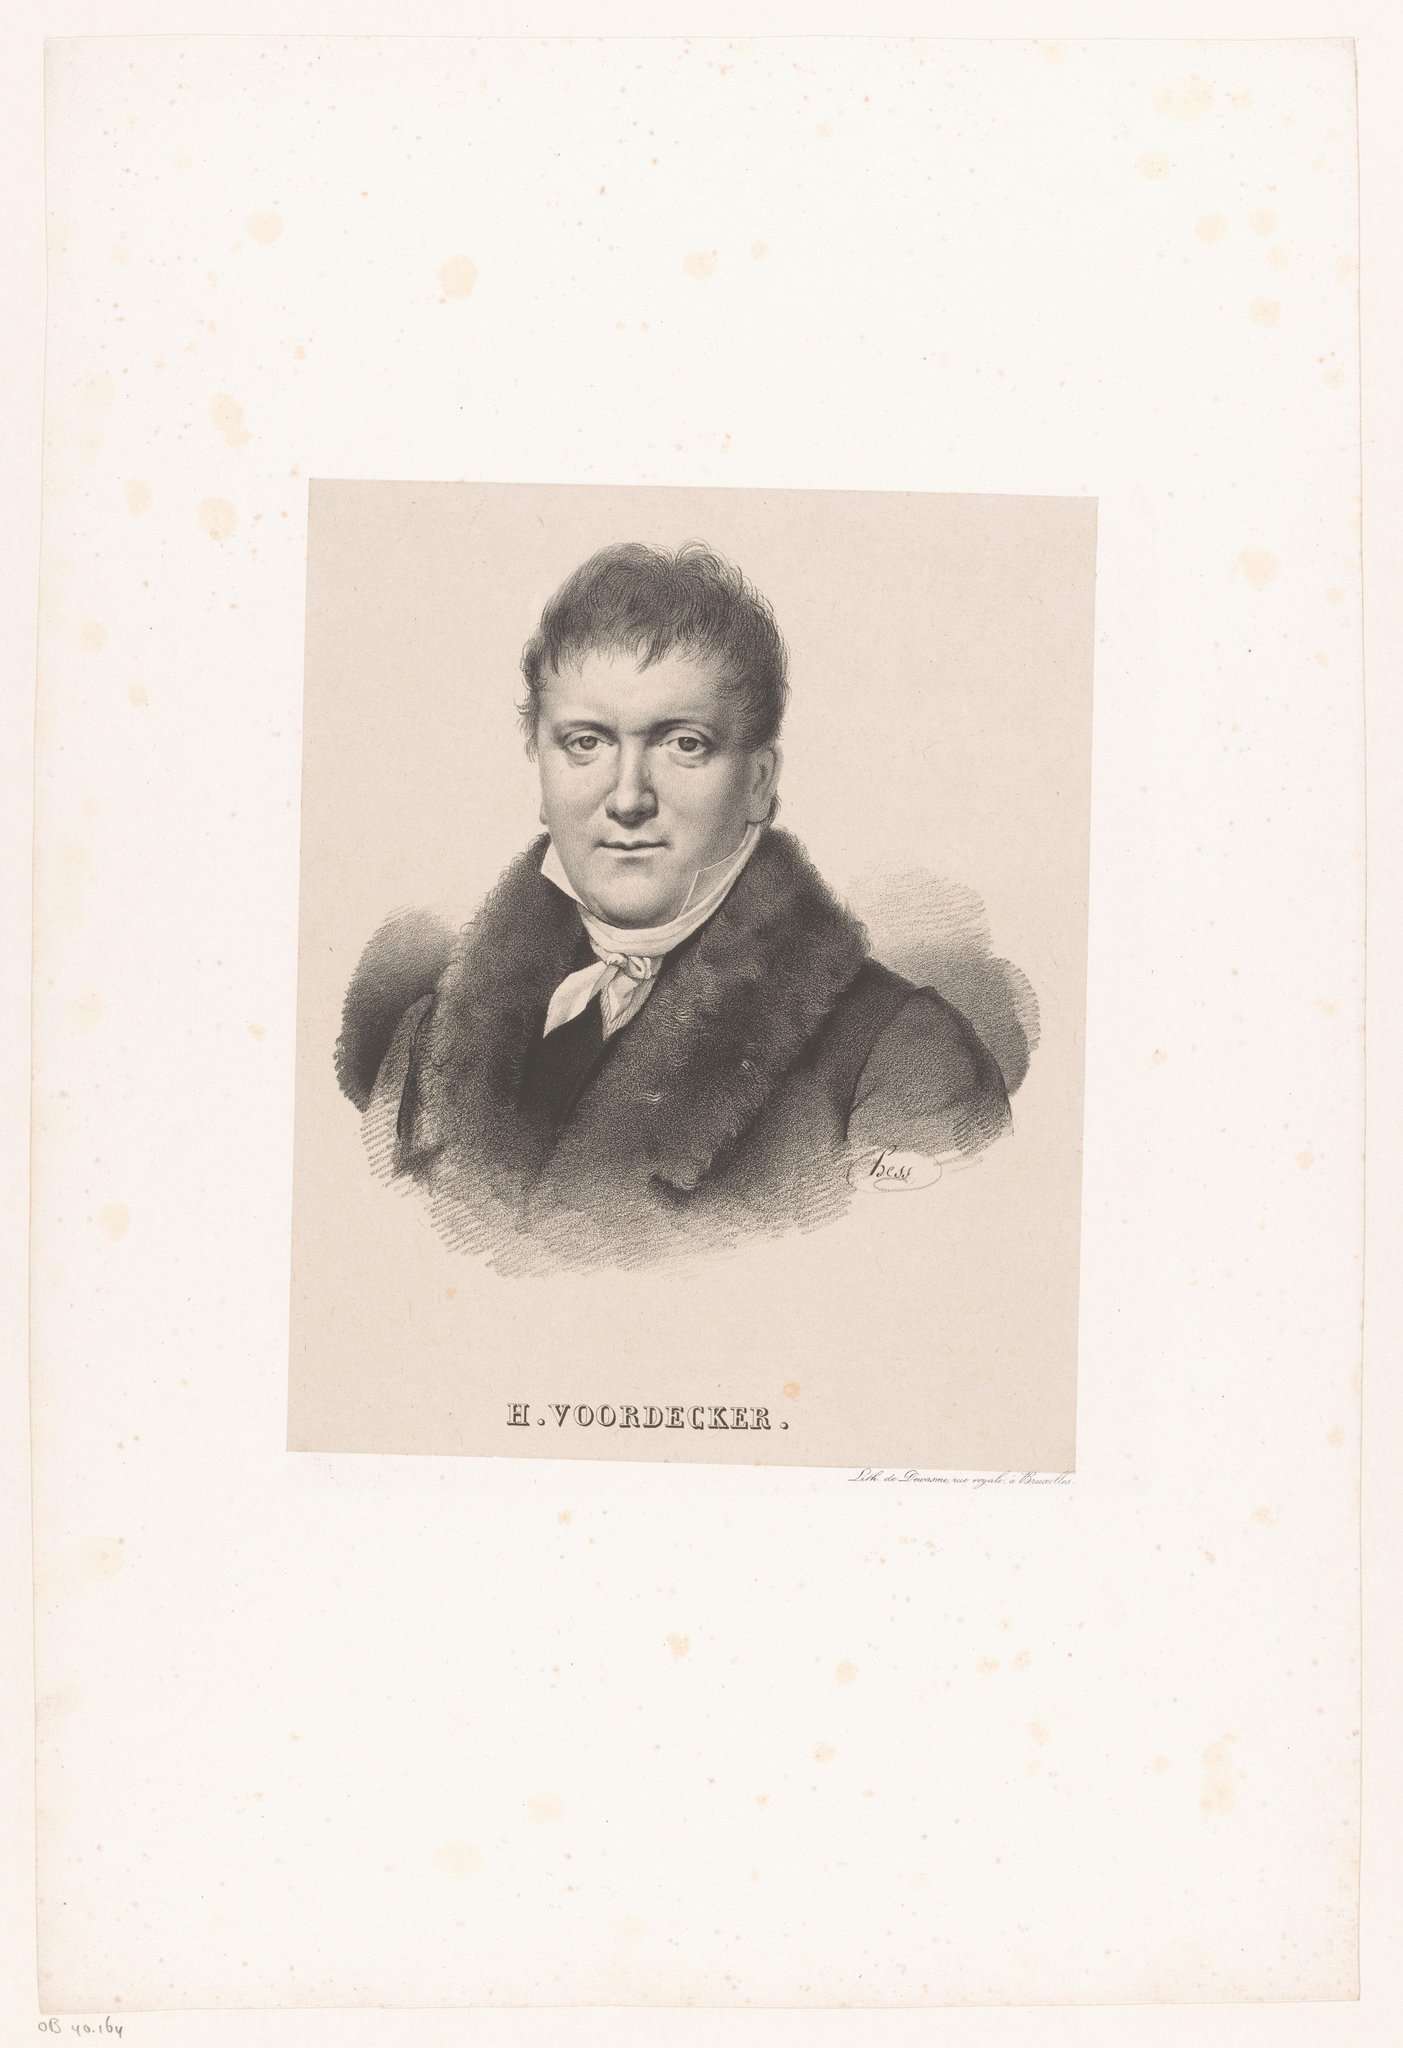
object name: print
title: Portret van Henri Voordecker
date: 1825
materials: paper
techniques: lithograph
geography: brussels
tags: brussels, painter, print maker, henri voordecker, adult man, historical persons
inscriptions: collector's mark: Lugt 2228